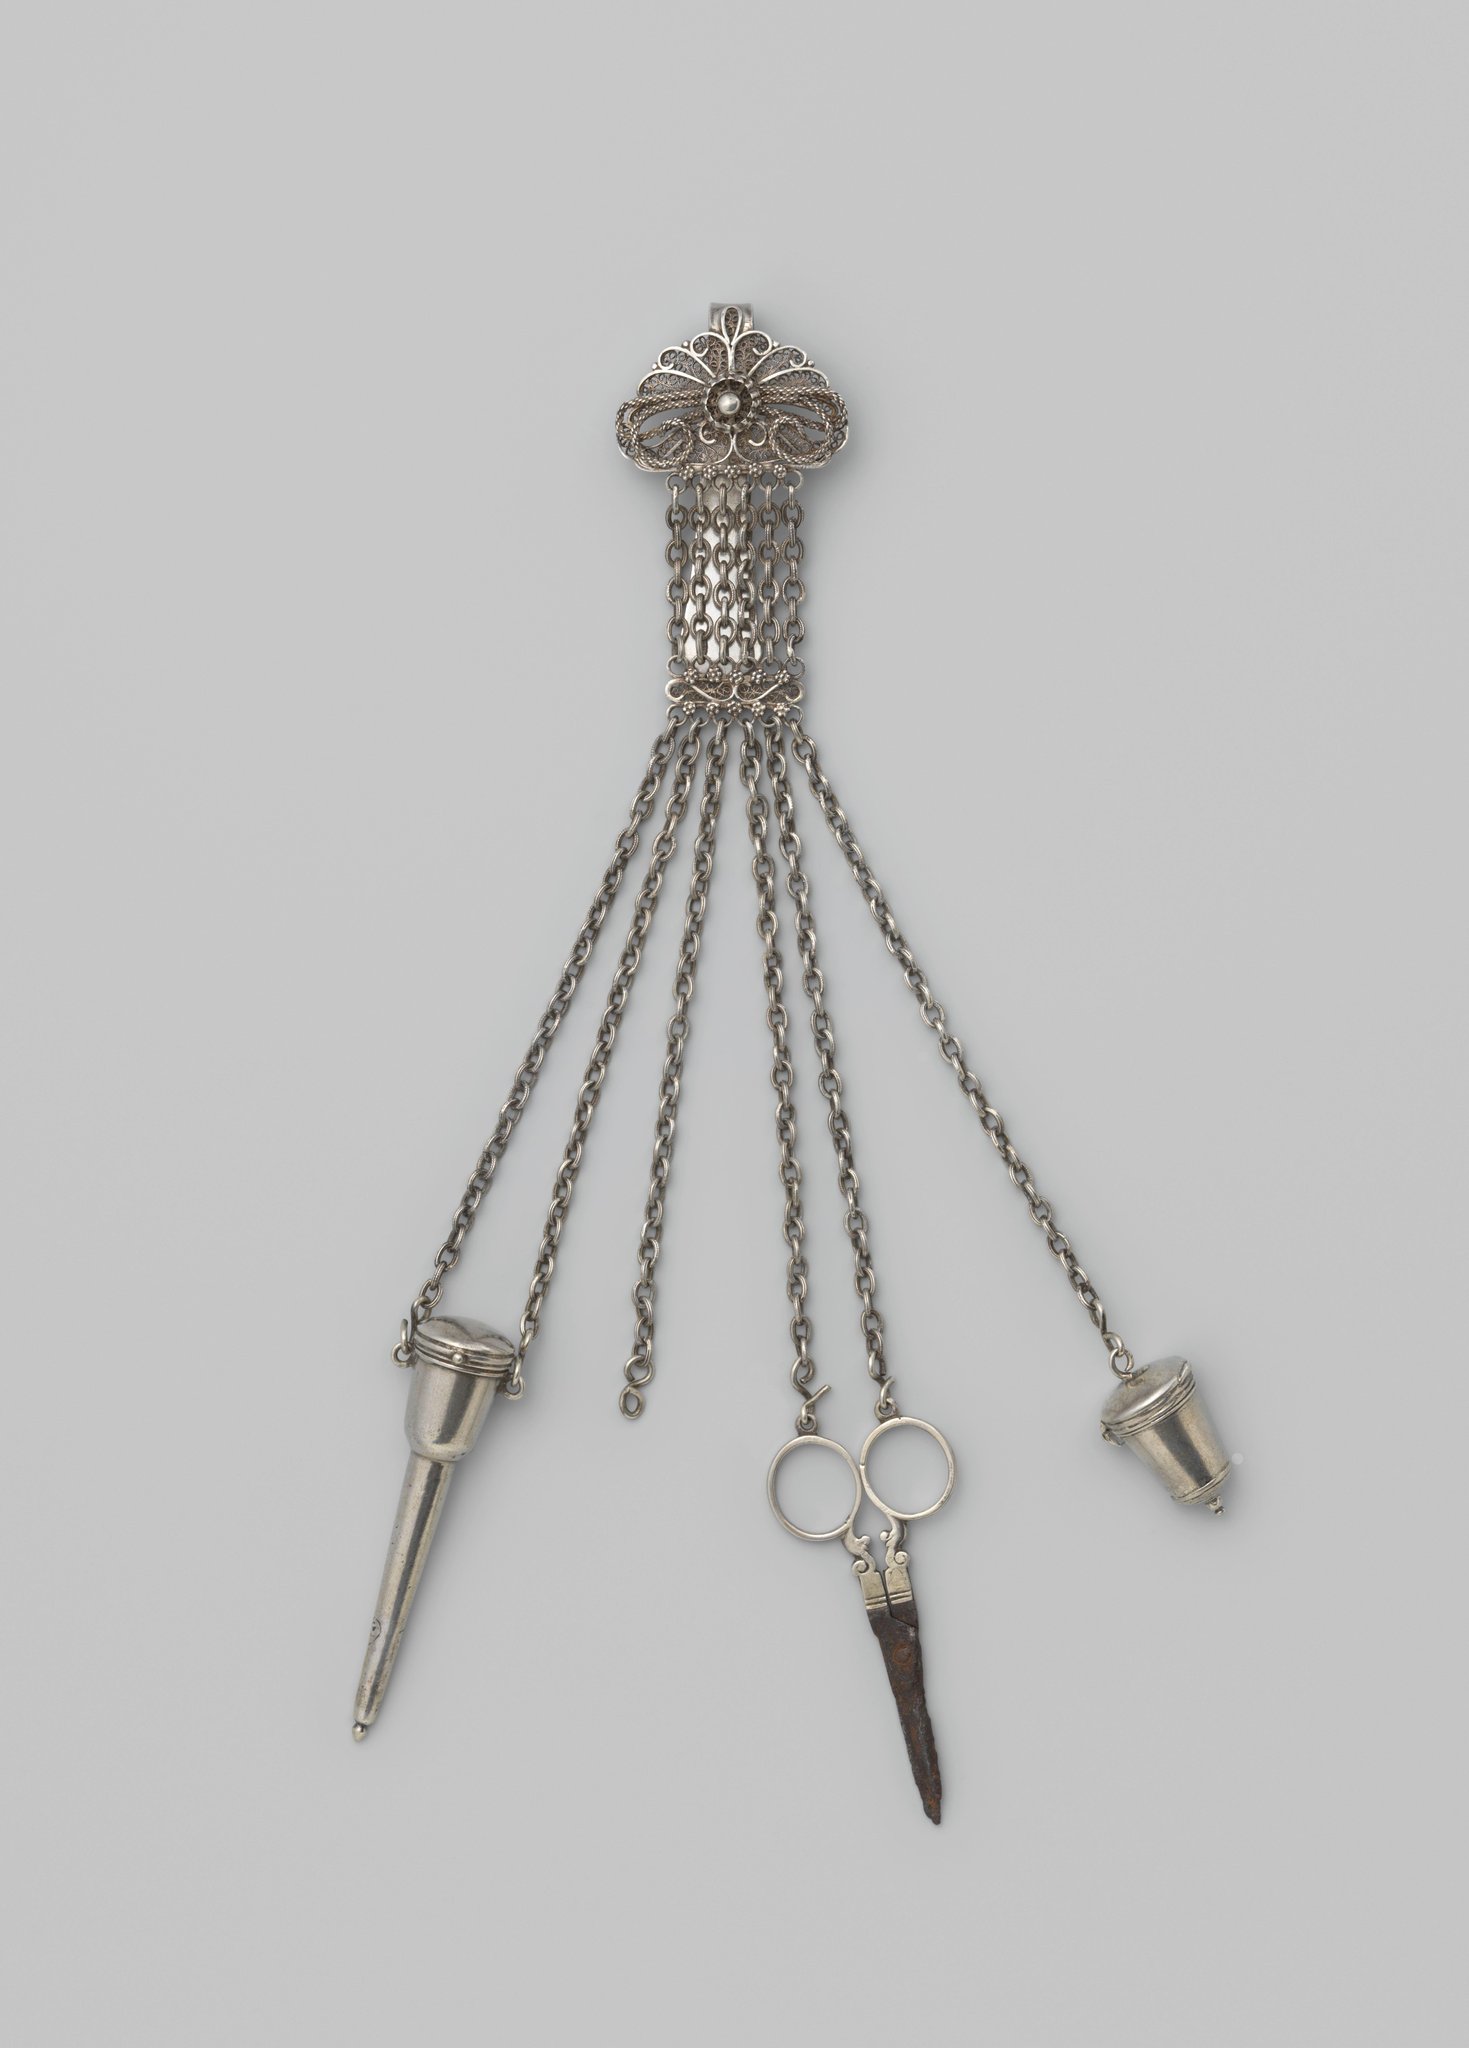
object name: handwerkgerei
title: Chatelaine met schaar, naaldenkoker en vingerhoedhuisje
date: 1780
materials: iron, silver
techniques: filigree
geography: amsterdam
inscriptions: alloy mark, maker's mark, town mark, mark, date letter: ‘V’, town mark, date letter: ‘V’, town mark, maker's mark, town mark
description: De chatelaine bestaat uit een een gordelhaak met daarop een in filigrein-techniek vervaardigd, uit voluten samengesteld ornament met centraal een knop omgeven door een parelrand, waaraan zes schakelkettingen zijn bevestigd, die worden onderbroken door een filigrein tussenstrook en waaraan met S-vormige verbindingsstukken de naaldenkoker, het vingerhoedhuisje en het schaartje hangen. Aan een van de kettingen hangt niets. De kettingen bestaan uit ovale, geribde schakels. De naaldenkoker bestaat uit een conisch deel met een geprofileerde bovenrand en een scharnierend deksel, waaronder een lang, spits toelopend gedeelte, eindigend in een pegeltje. Het vingerhoedhuisje, dat zeer verwant is aan het bovengedeelte van de naaldenkoker, heeft een bolle, geprofileerde onderzijde waaronder twee in grootte afnemende bolletjes zijn bevestigd. De schaar heeft ijzeren benen.